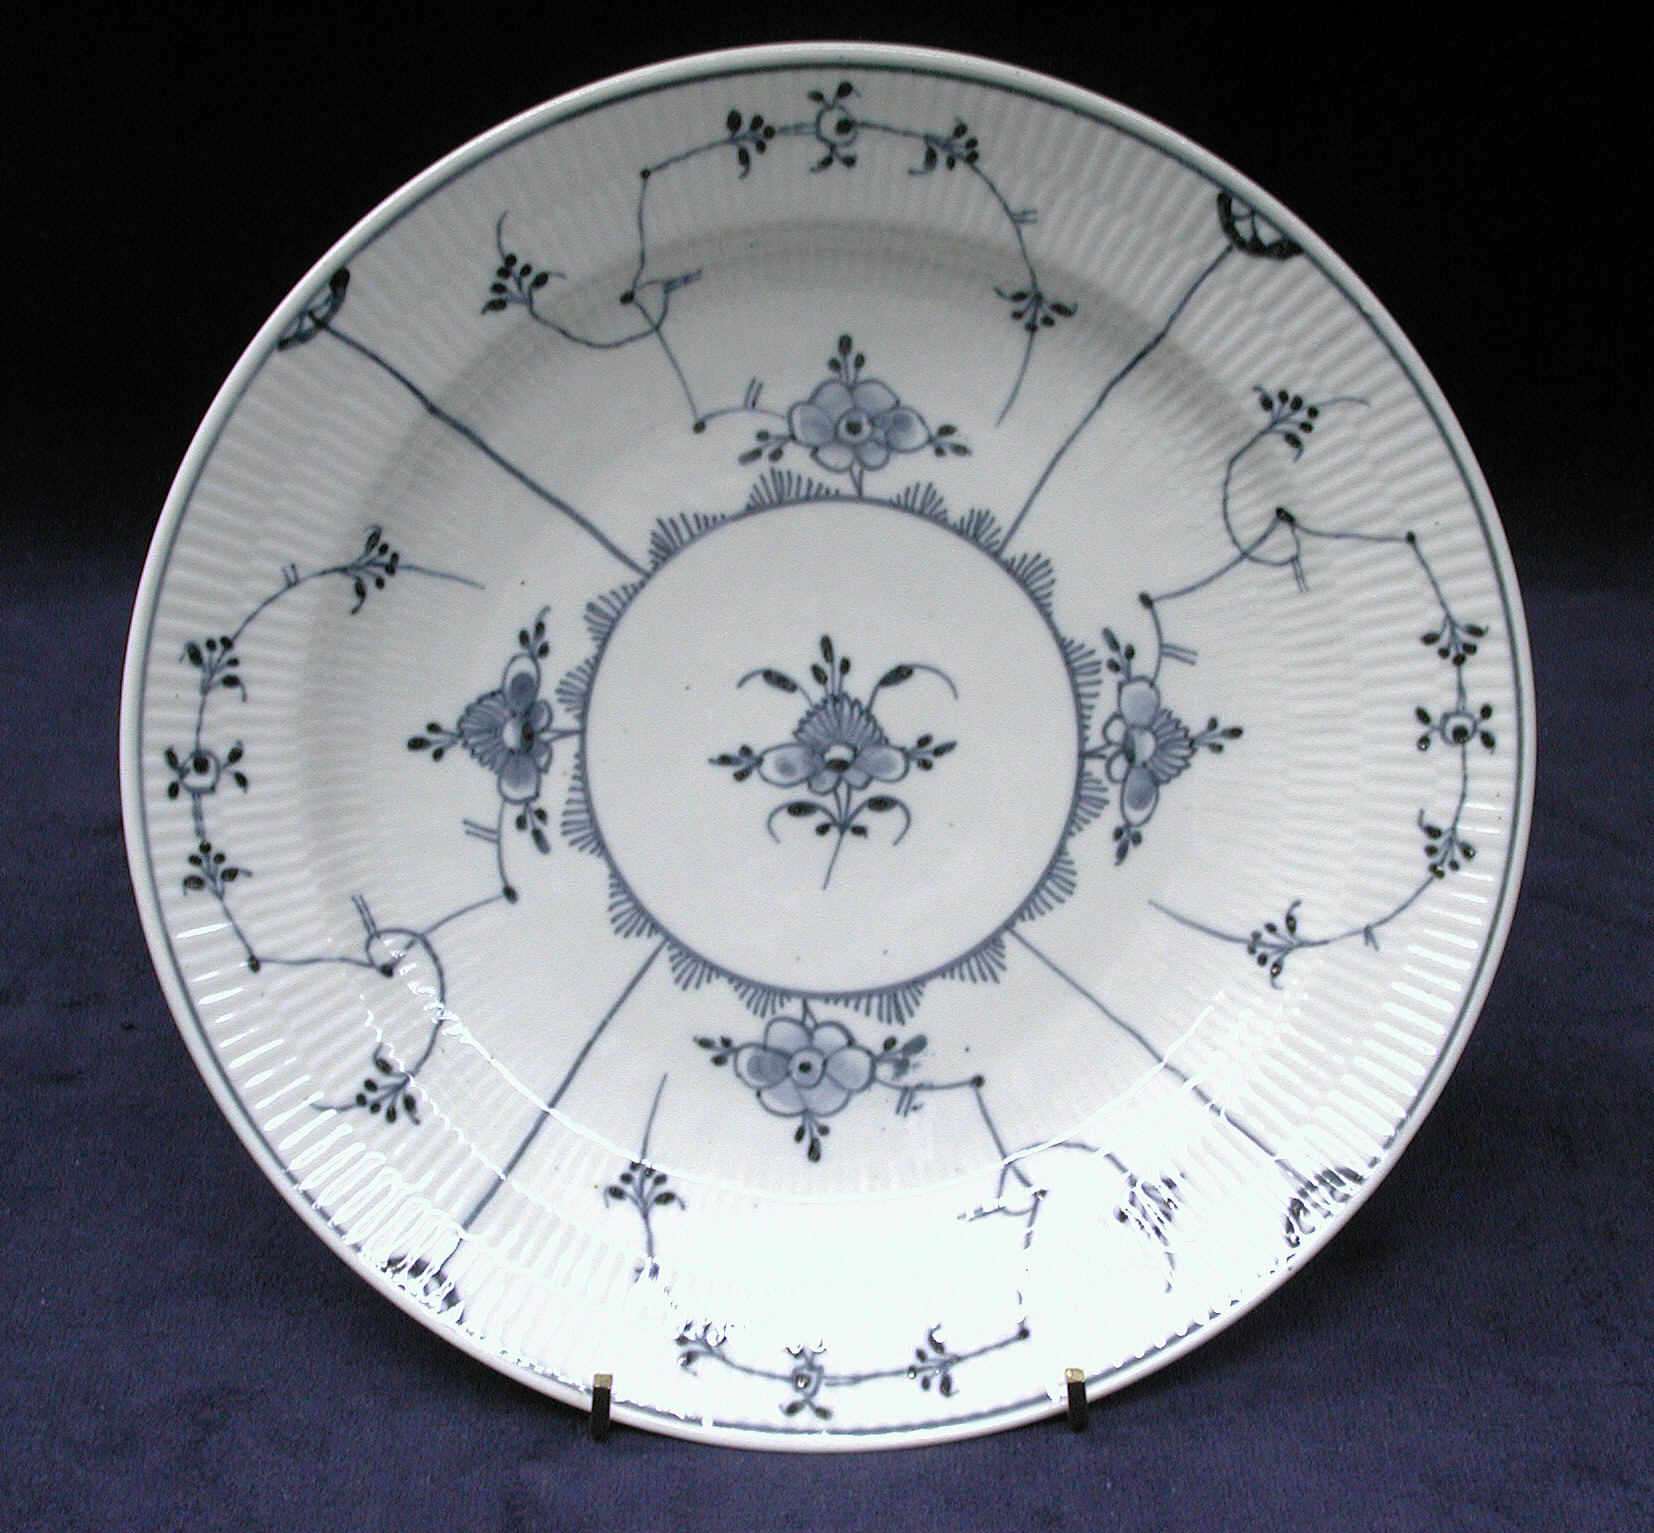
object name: plate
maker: wallendorf porcelain manufactory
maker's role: manufactory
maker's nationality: german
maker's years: 1764-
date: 1767-1800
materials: hard paste porcelain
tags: flowers